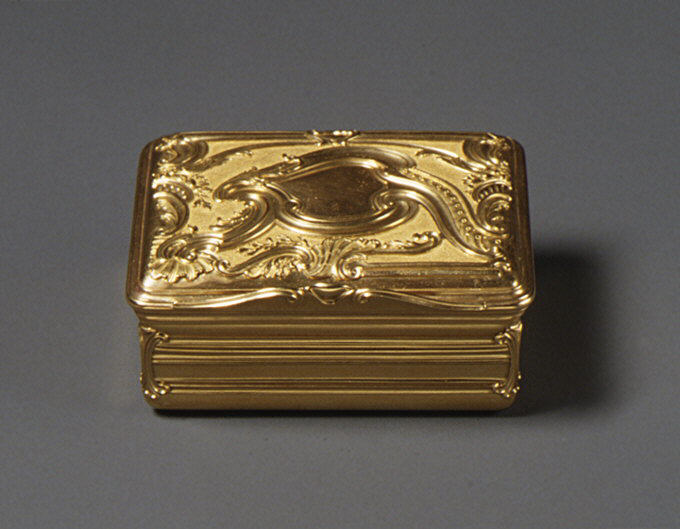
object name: snuffbox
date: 1760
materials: gold